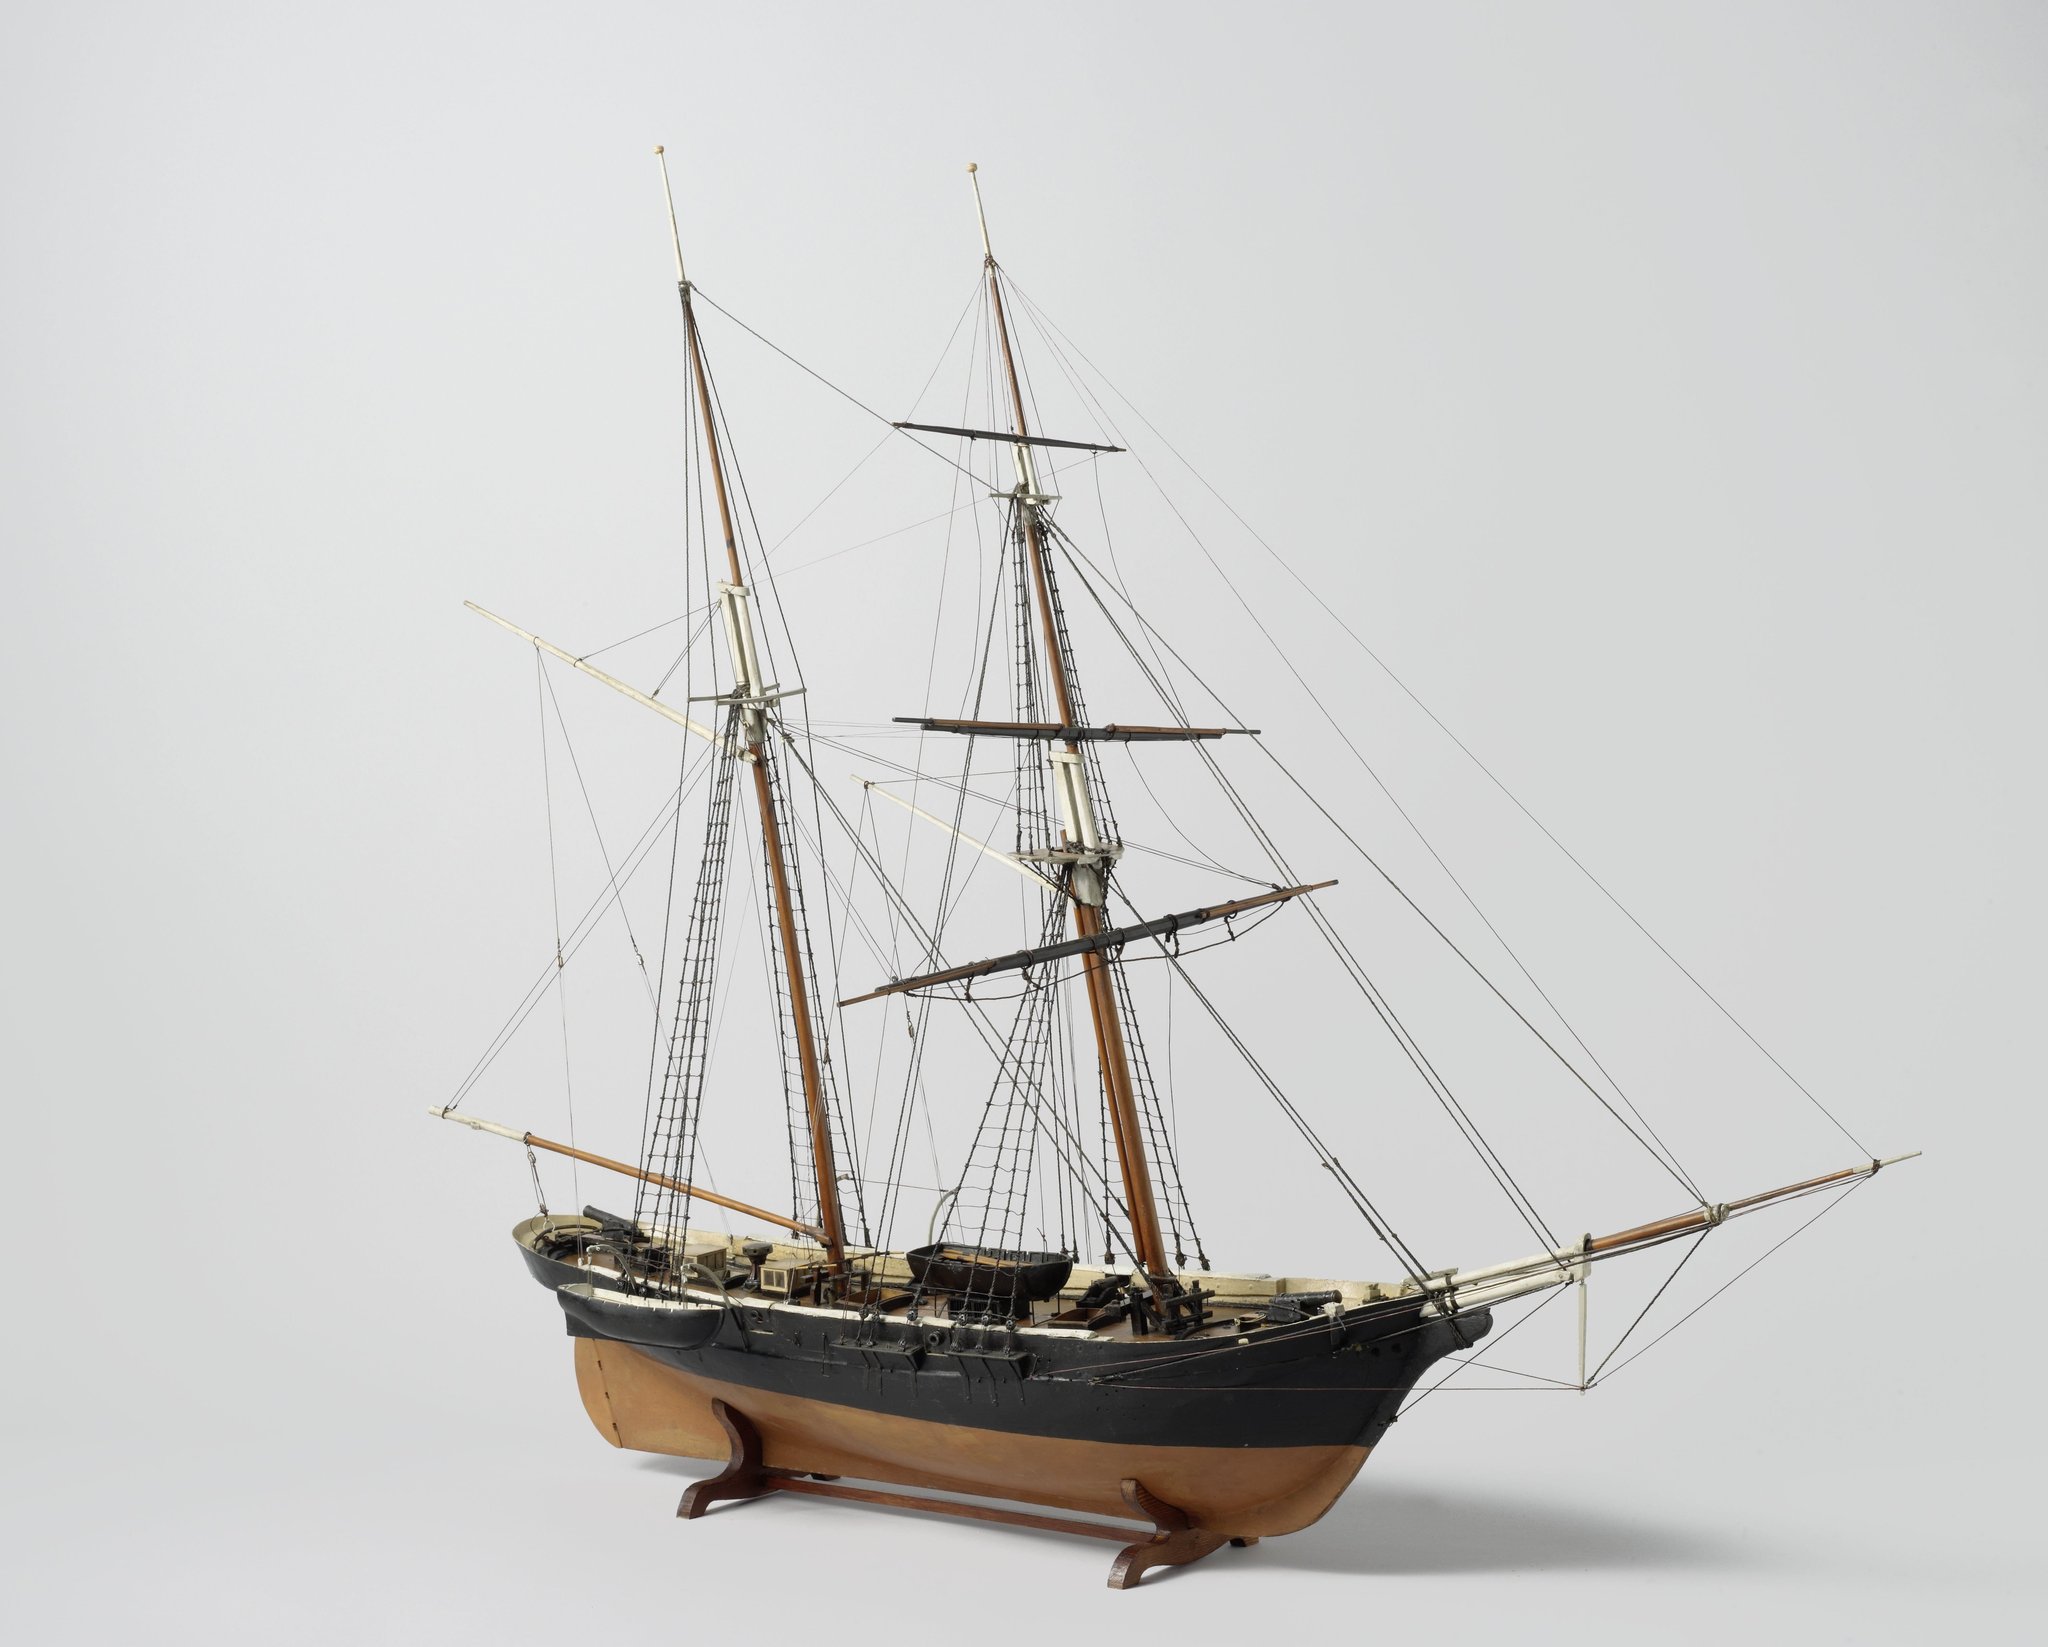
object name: fully rigged model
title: Model of the schooner Banka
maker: Anonymous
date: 1843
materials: fiber, wood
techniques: polychromy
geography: netherlands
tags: names of artefacts and man-made objects (buildings excluded), sailing-ship, sailing-boat (schooner)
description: Schooners were built for speed and used for all kinds of purposes by the navy, from conveying messages to scouting and the pursuit of smugglers and pirates. They developed in the 18th century in North America as light merchant vessels that could rapidly transport goods and passengers. This speed made schooners suitable vessels for naval tasks and, from the 19th century, even for races.